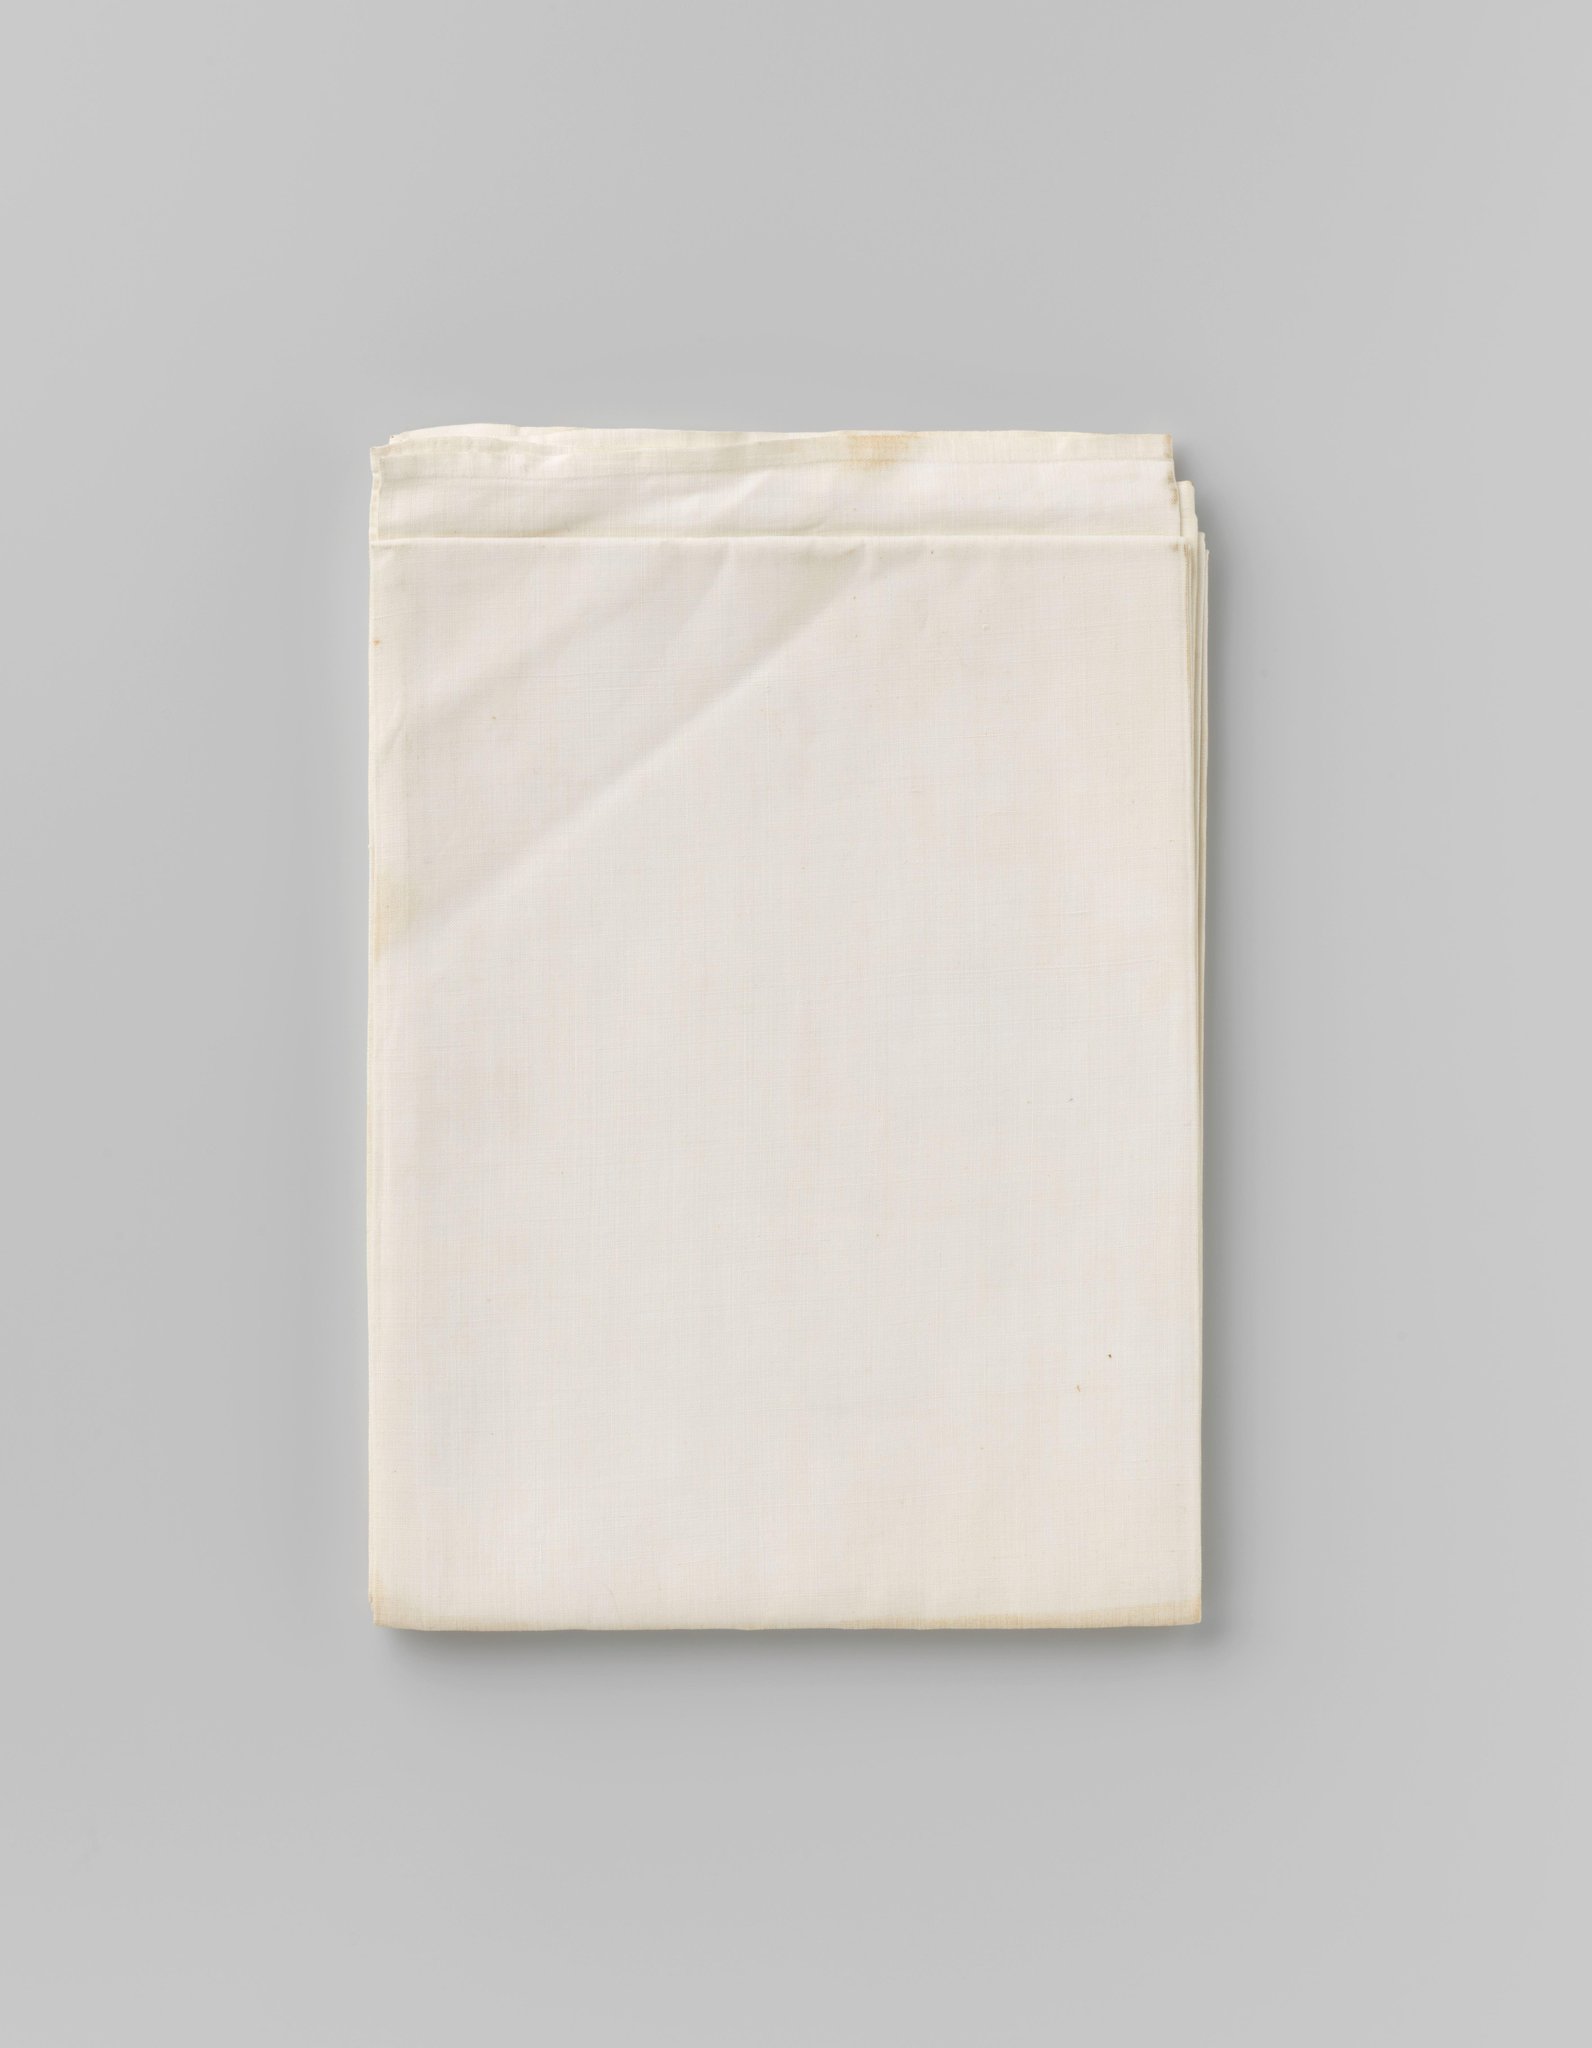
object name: beddenlaken, laken object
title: Laken. Merk: kroon G7 en jaartal 1773.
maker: Anonymous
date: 1773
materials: linen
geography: northern netherlands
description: Laken van wit linnen, merk kroon G7 en jaartal 1773